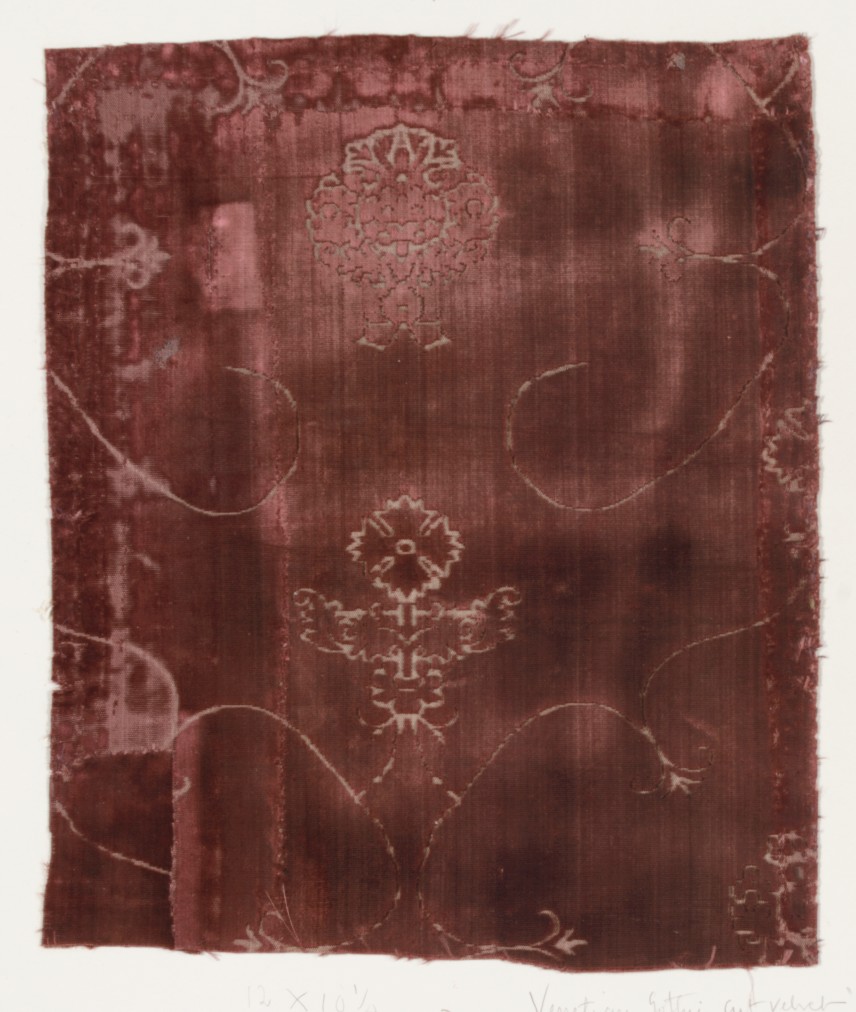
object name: fragment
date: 1401-1600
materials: silk